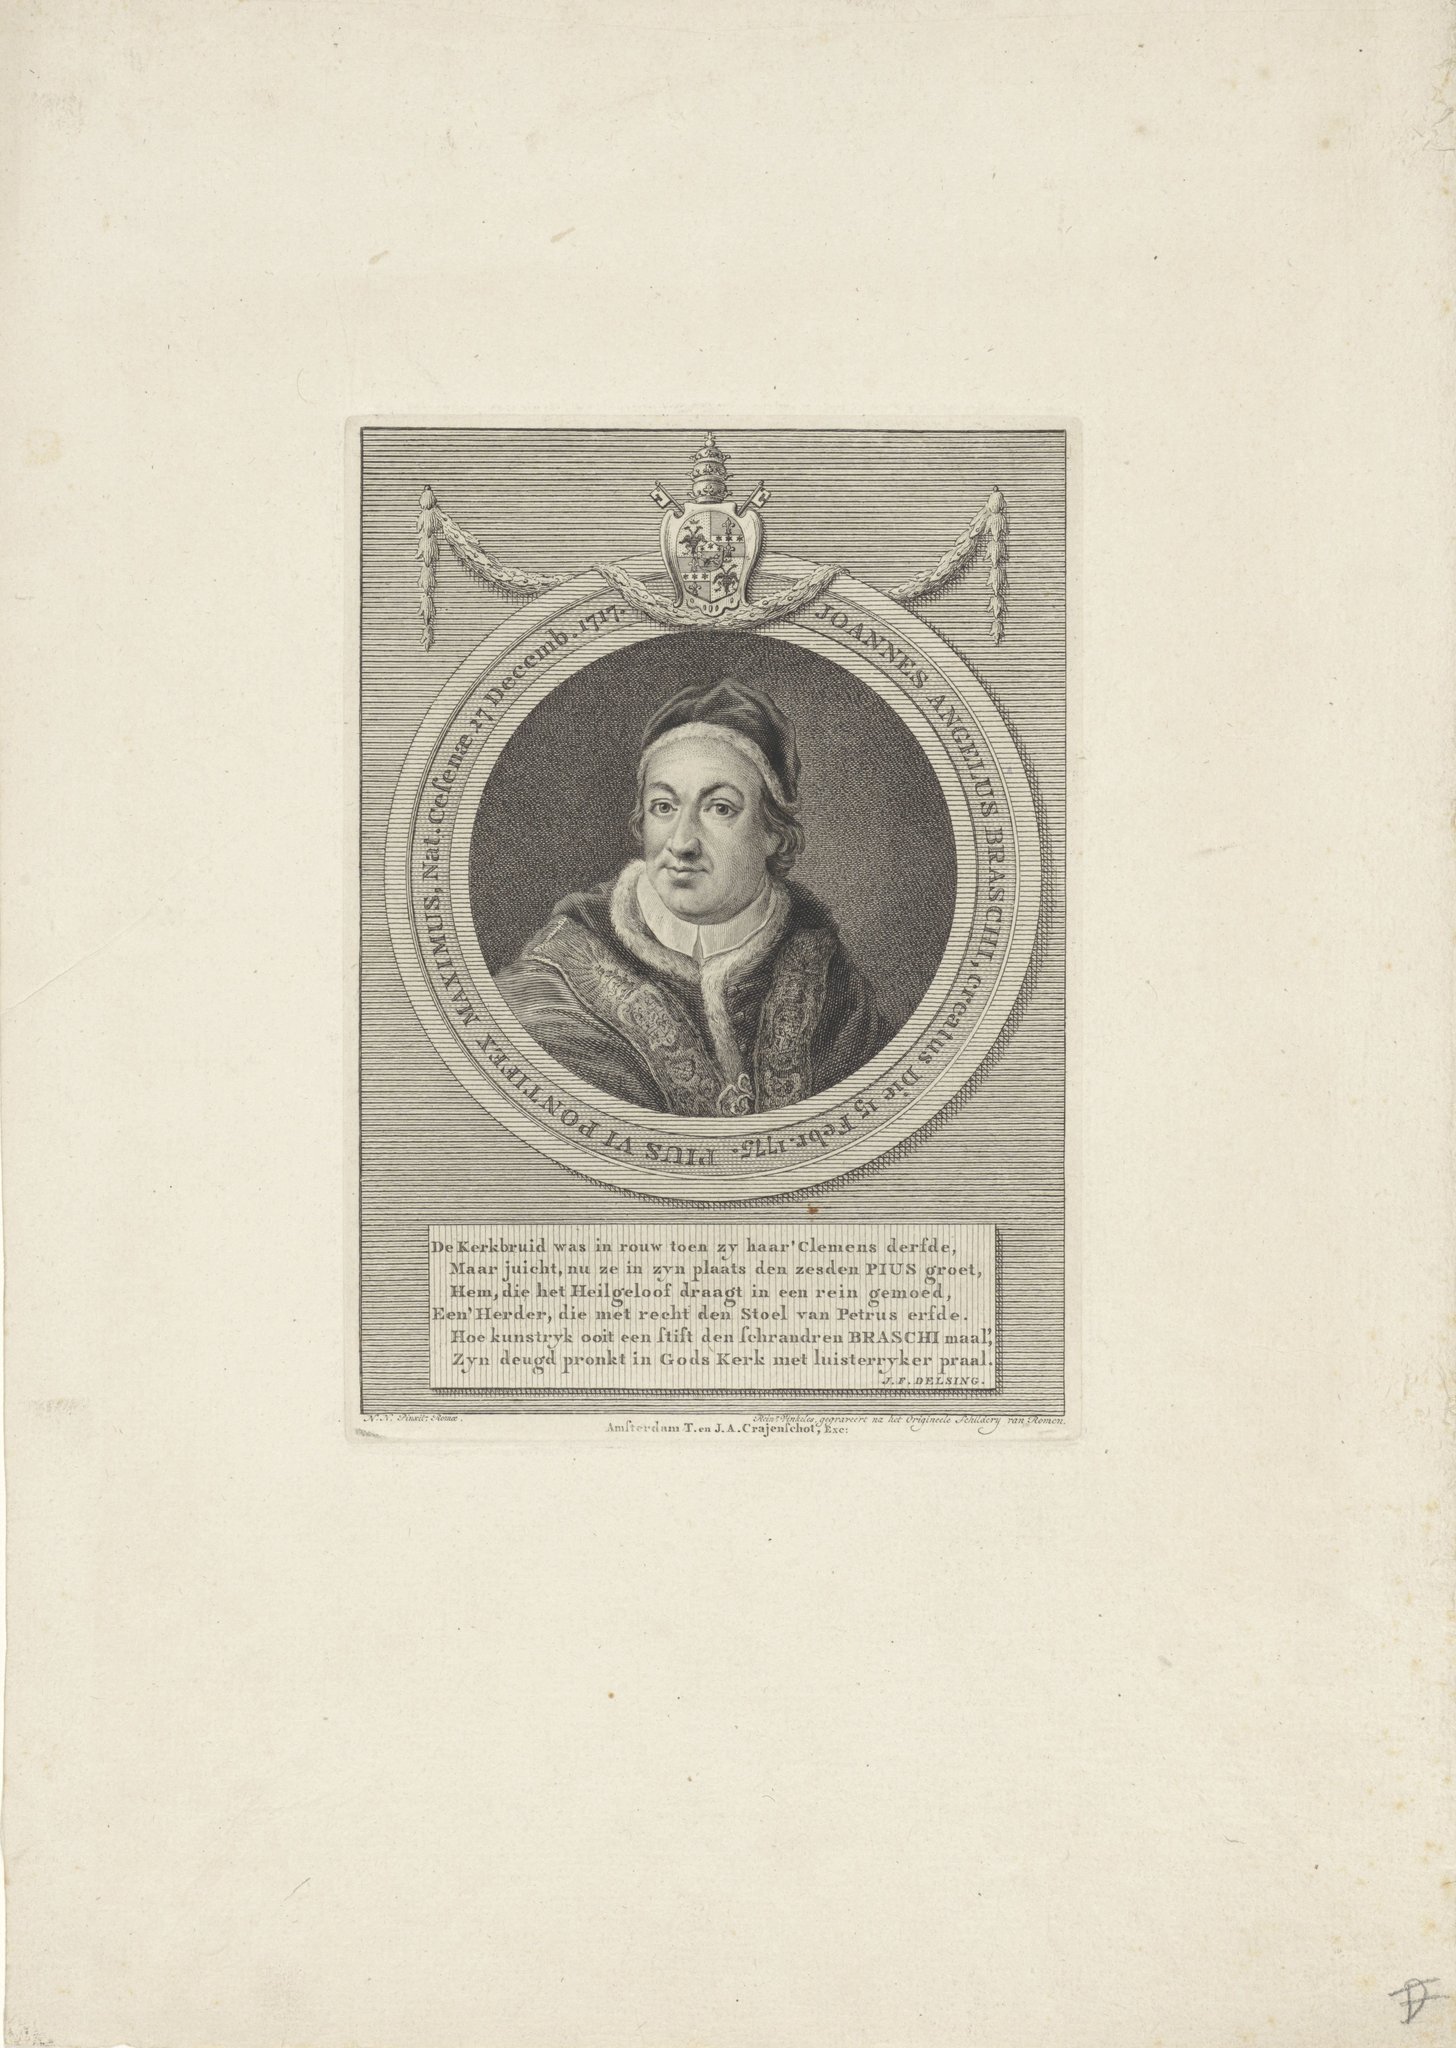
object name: print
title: Portret van paus Pius VI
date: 1775-1777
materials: paper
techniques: engraving, etching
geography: amsterdam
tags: pius vi, historical persons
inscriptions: collector's mark: Lugt 240